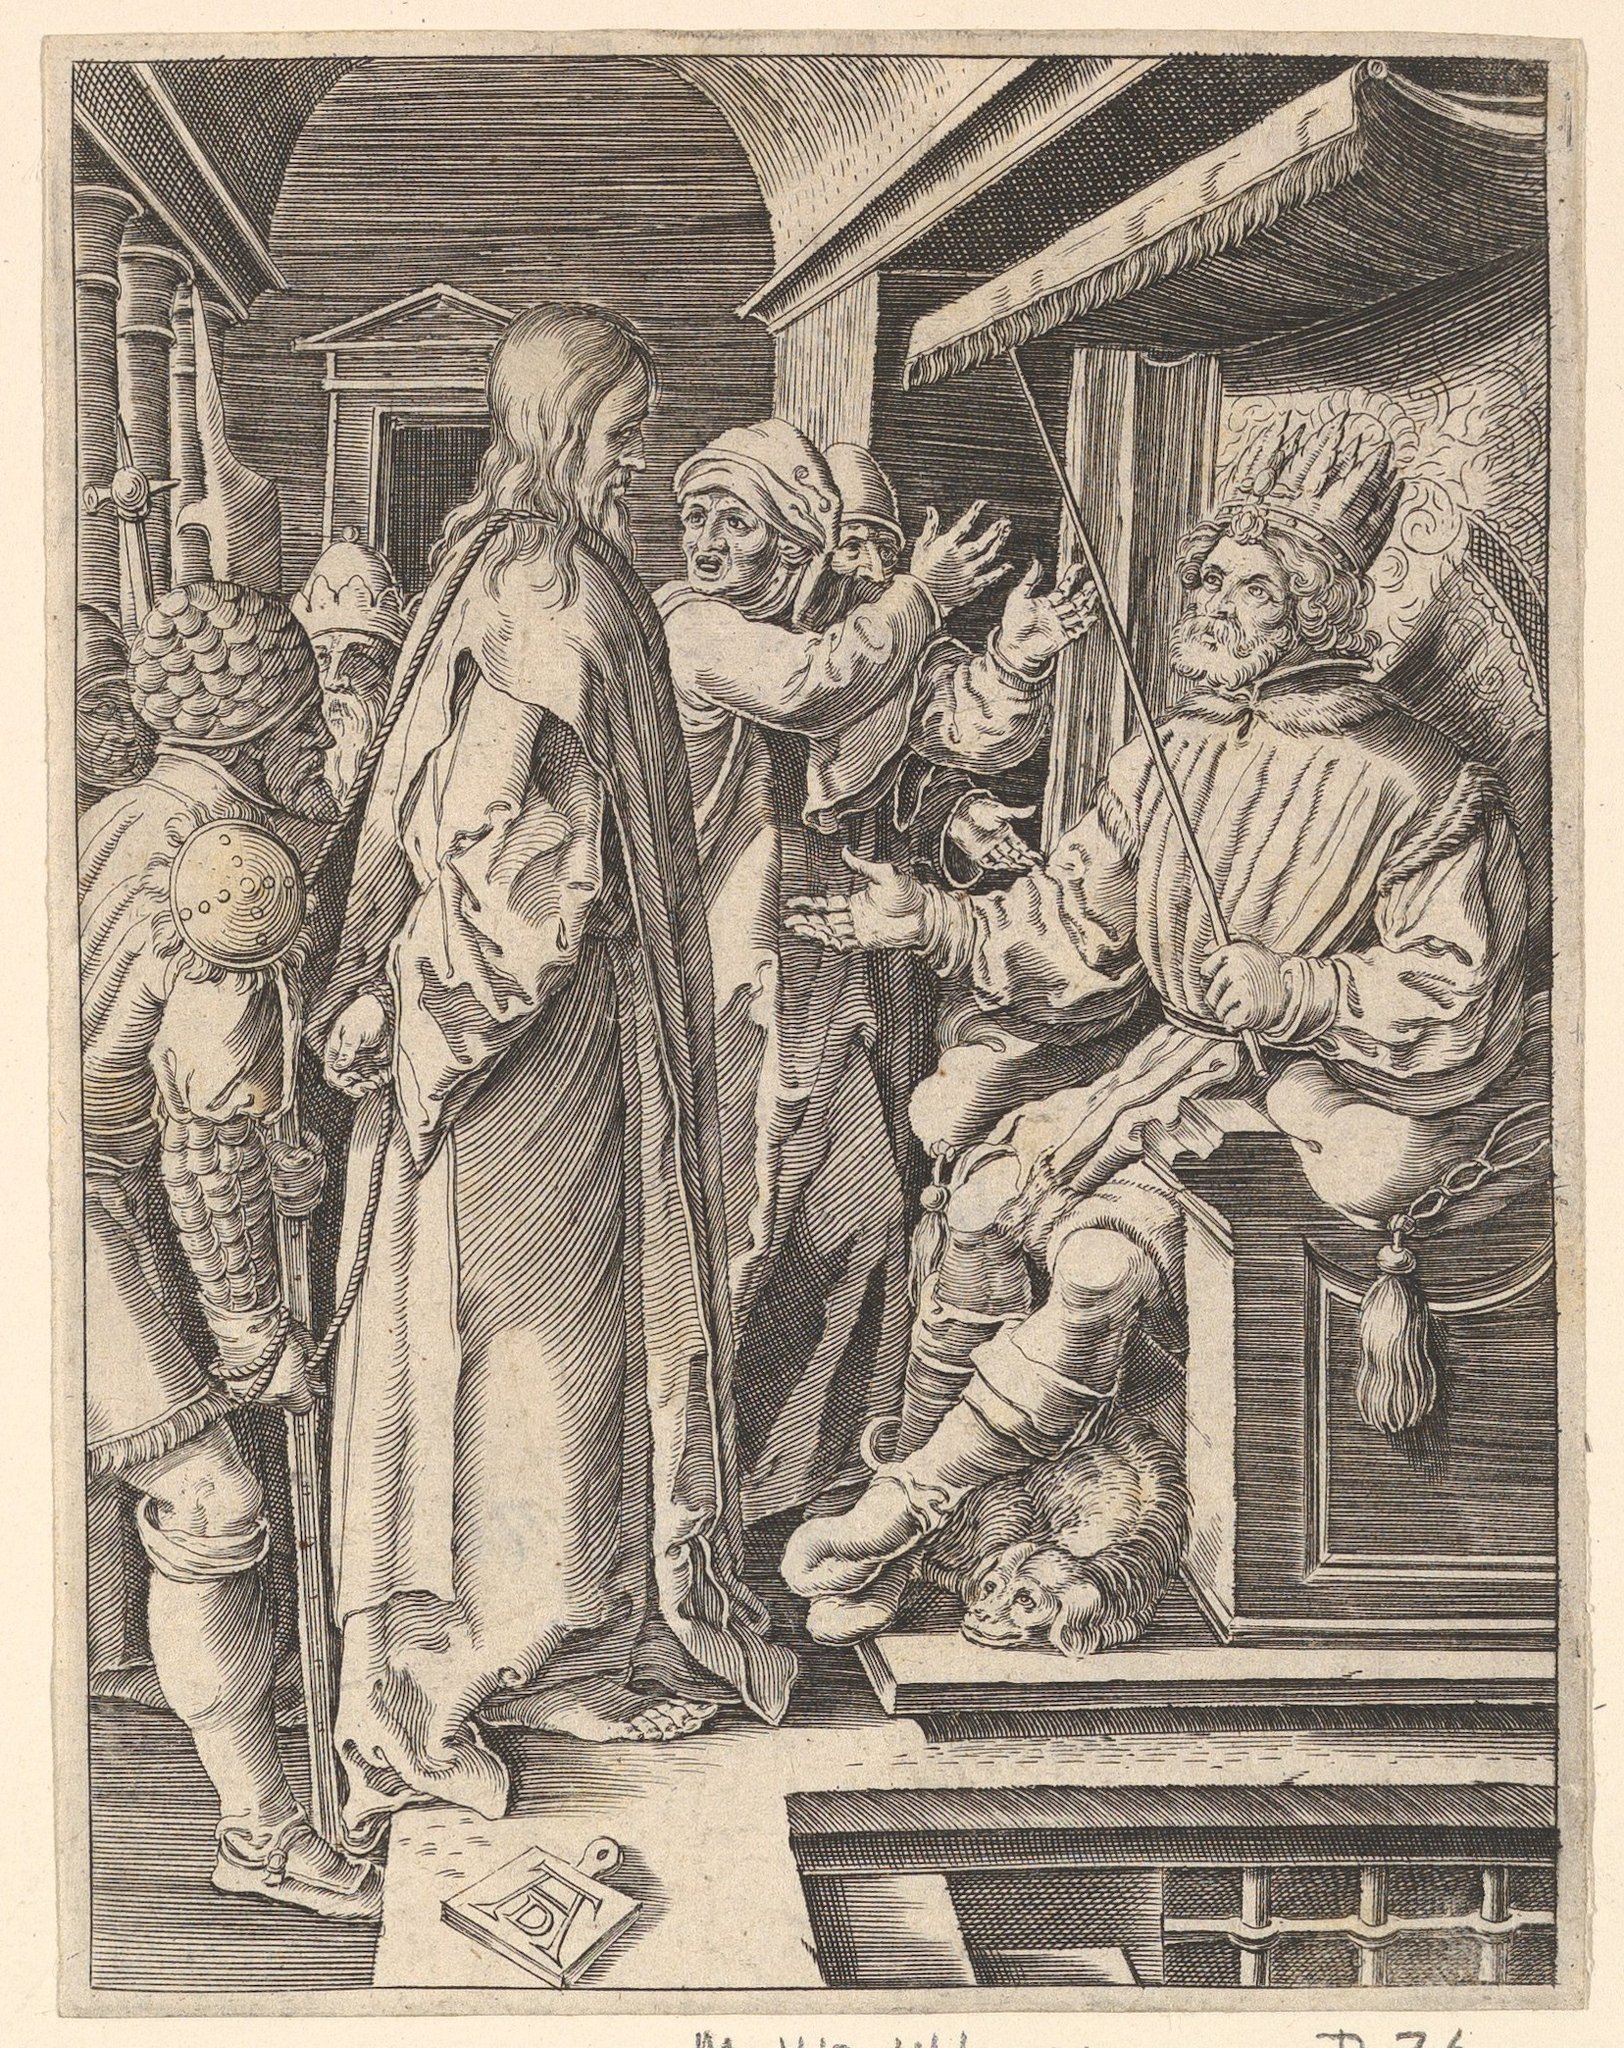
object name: print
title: Engraved copies of The Little Passion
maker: albrecht dürer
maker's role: artist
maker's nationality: german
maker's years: 1471-1528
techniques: engraving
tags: animals,soldiers,men,jesus